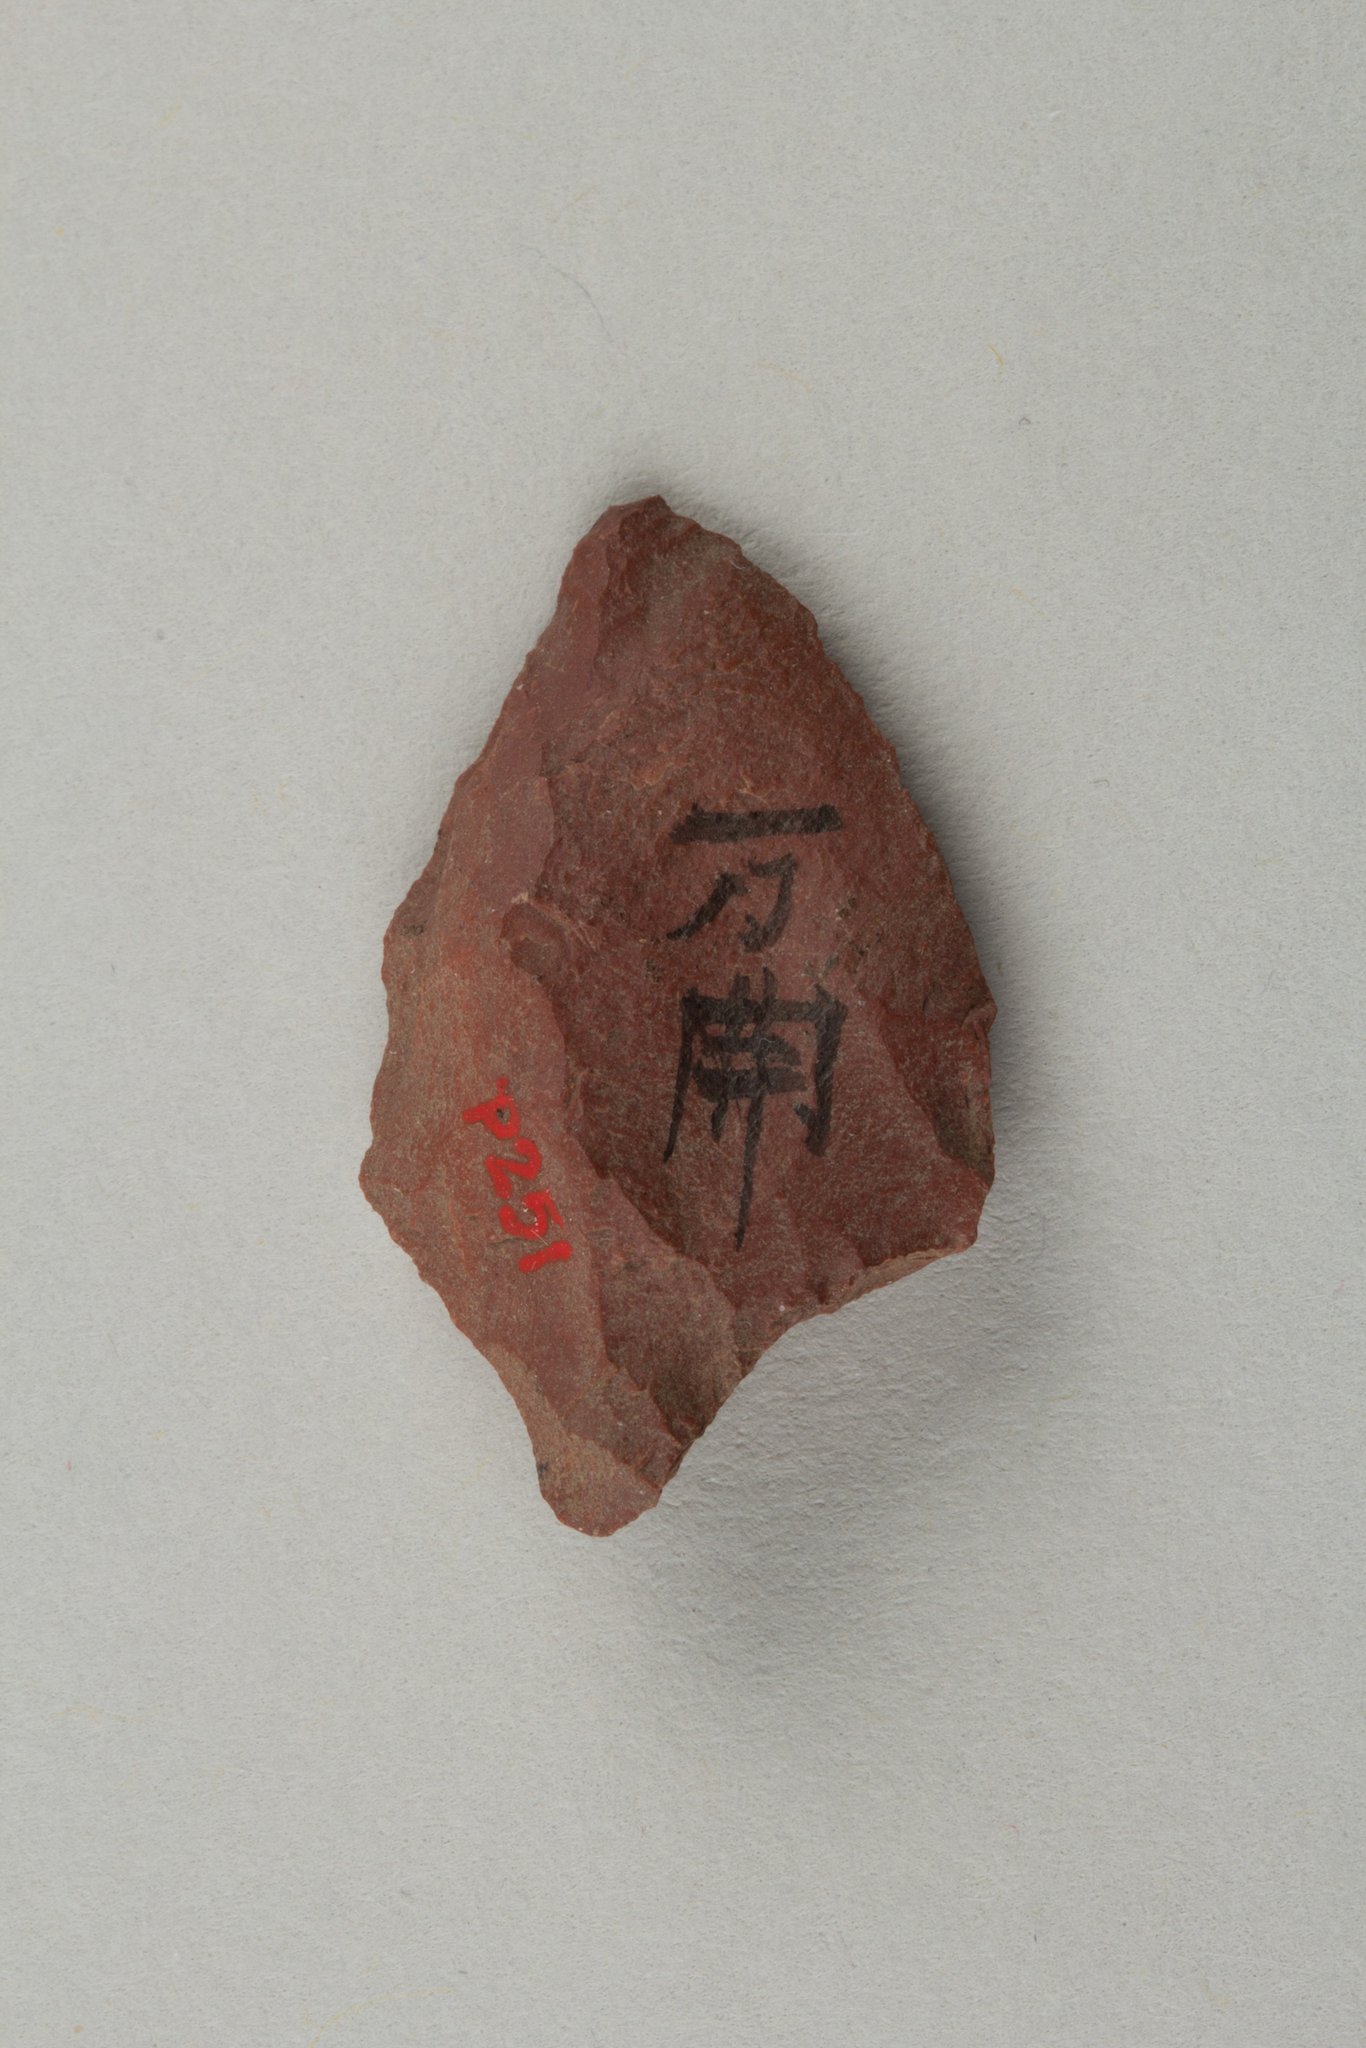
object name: arrowhead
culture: japanese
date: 1500-1000 BCE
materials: stone